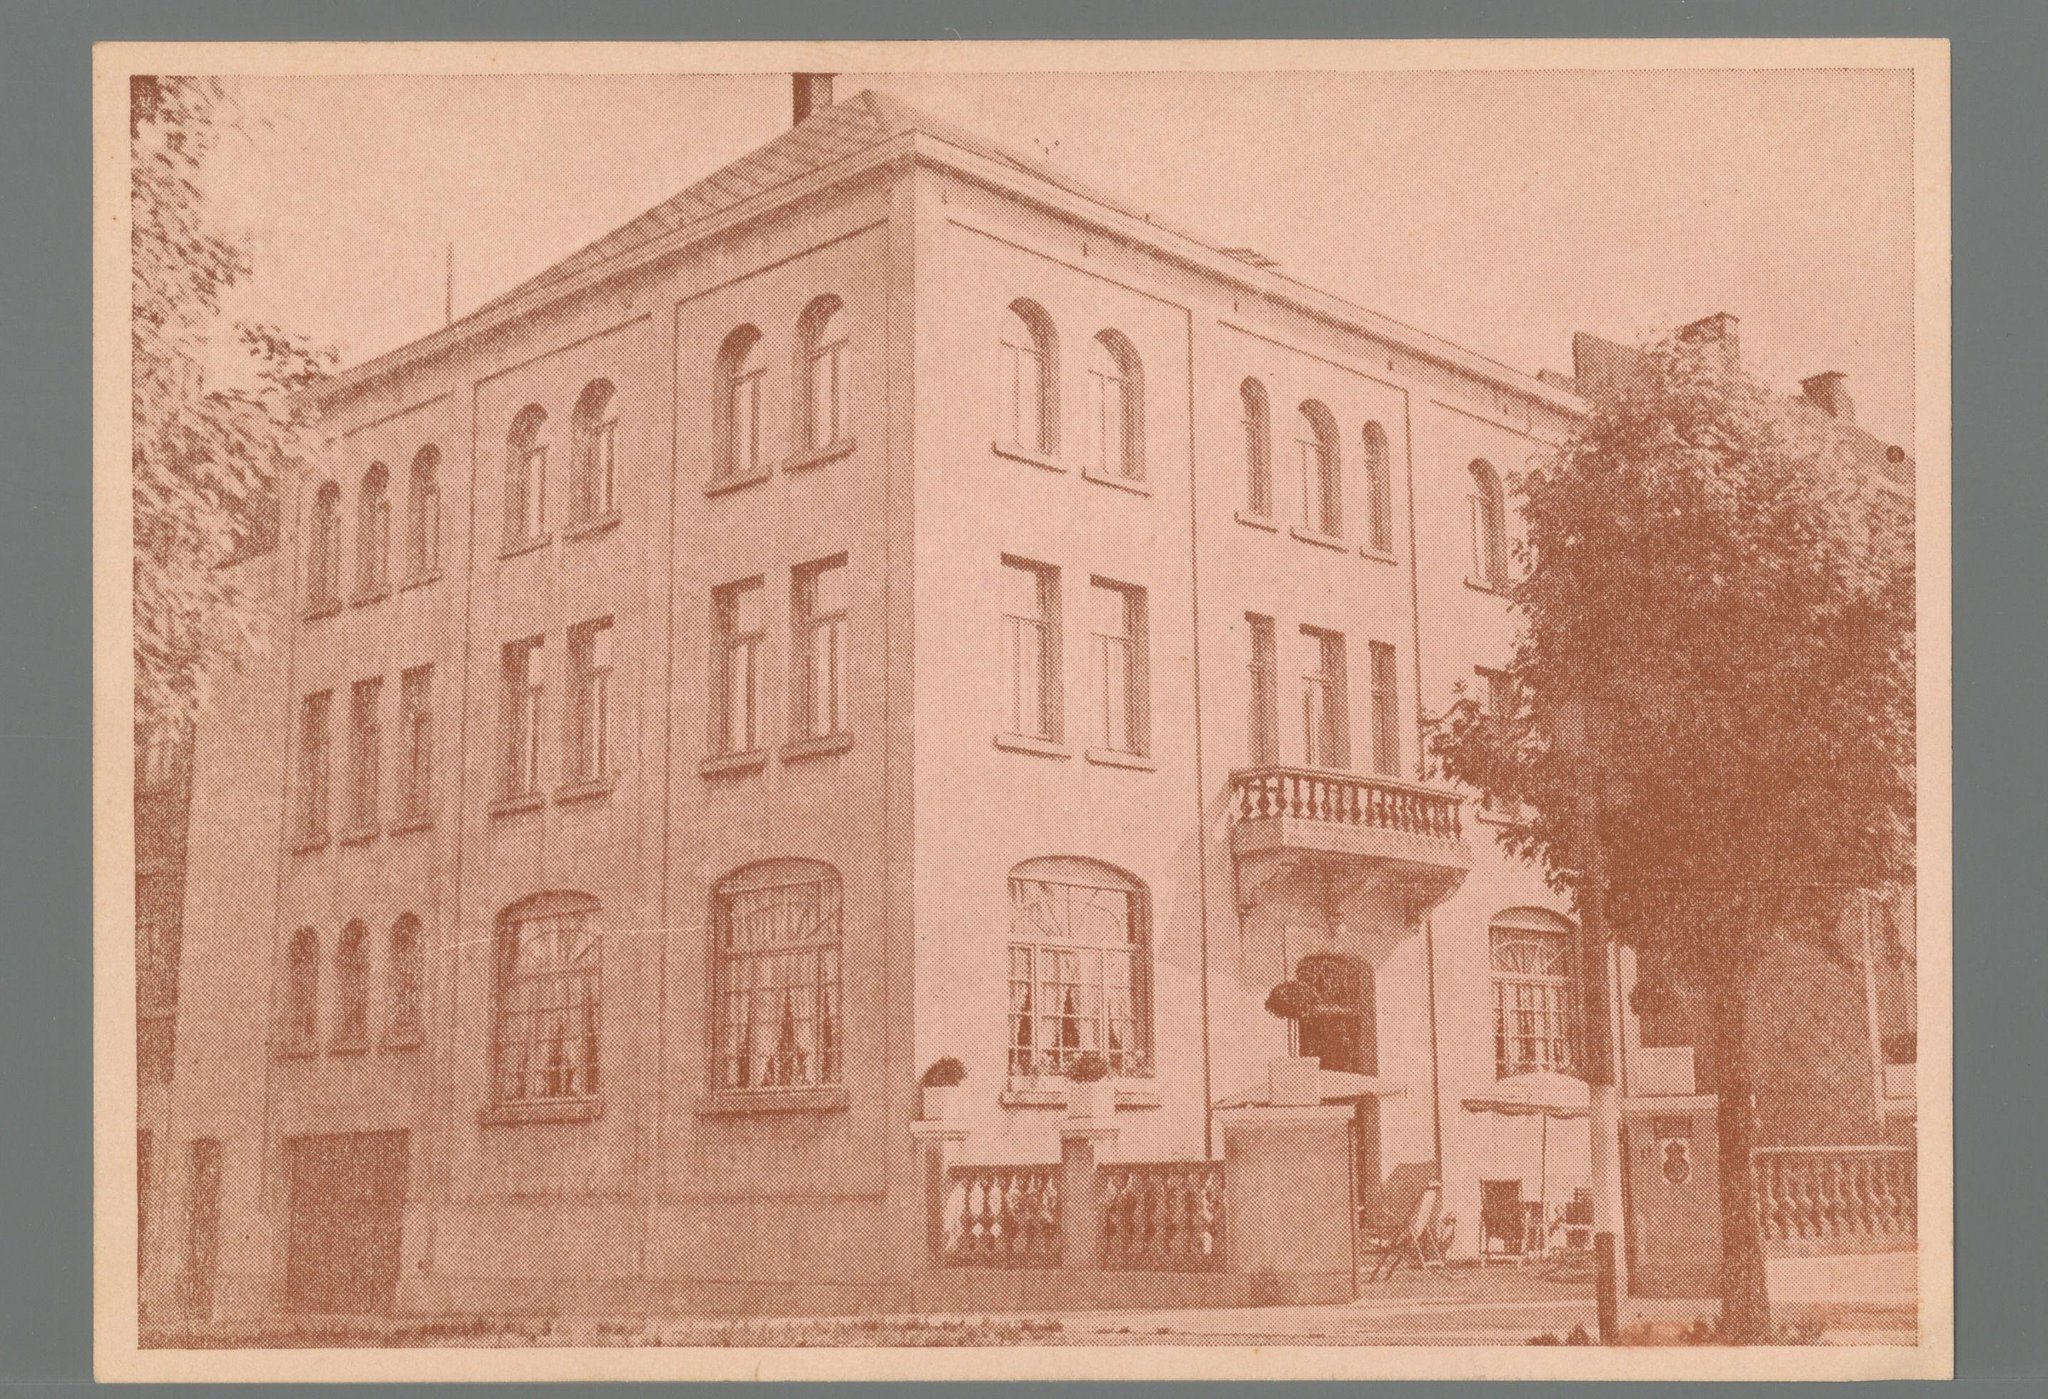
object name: photomechanical print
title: Hotel Leopold III (...) Bruxelles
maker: Anonymous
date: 1934-1955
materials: cardboard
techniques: writing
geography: brussels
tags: exterior ~ representation of a building, hotel, hostelry, inn